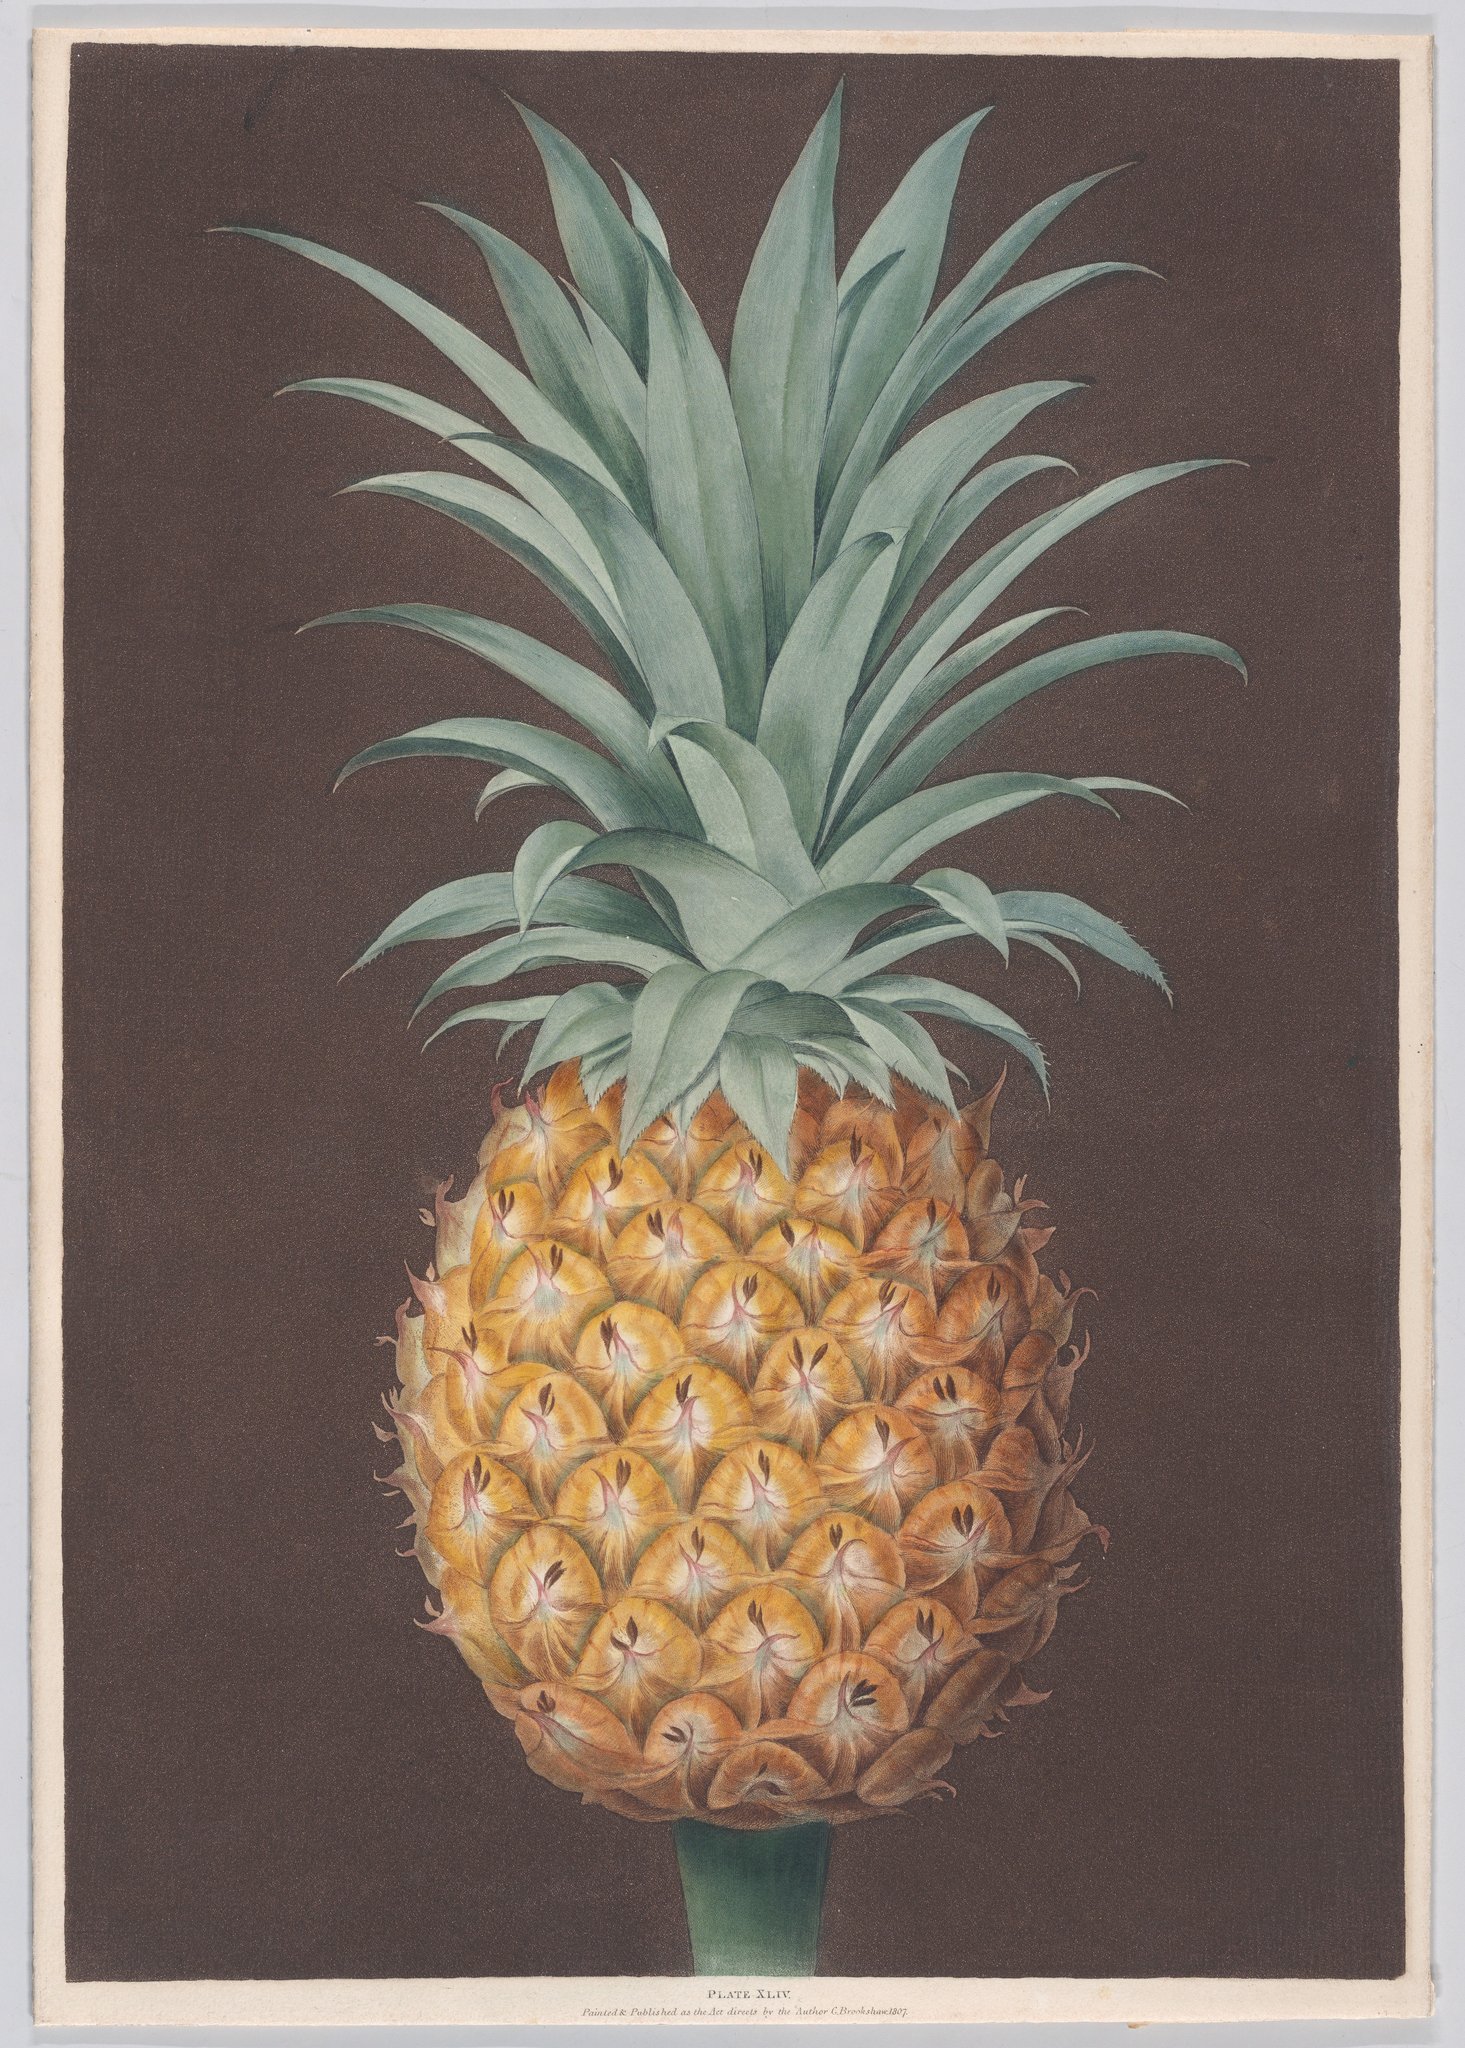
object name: print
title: The Smooth Leaved Green Antigua Pine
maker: george brookshaw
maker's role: artist and publisher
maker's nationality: british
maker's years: 1751-1823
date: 1807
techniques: aquatint, hand coloring, printing, stippling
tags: pineapples